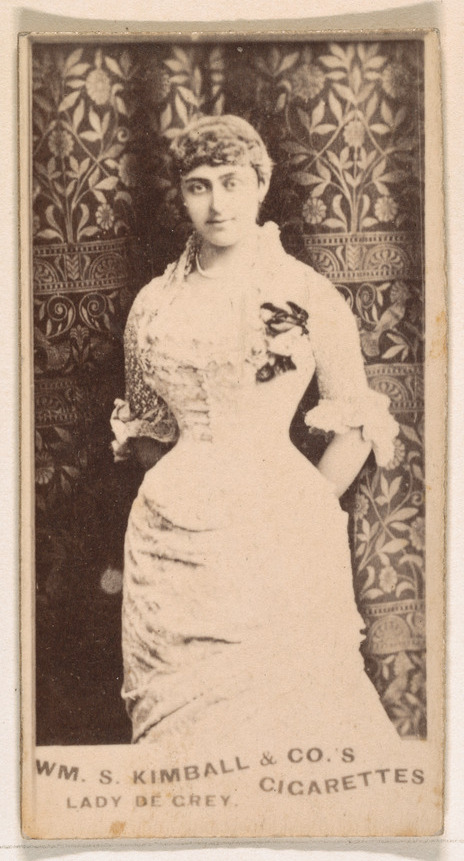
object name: photograph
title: Lady de Grey, from the Actresses series (N203) issued by Wm. S. Kimball & Co.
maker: william s. kimball & company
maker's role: publisher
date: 1889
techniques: color lithograph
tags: portraits,women,actresses